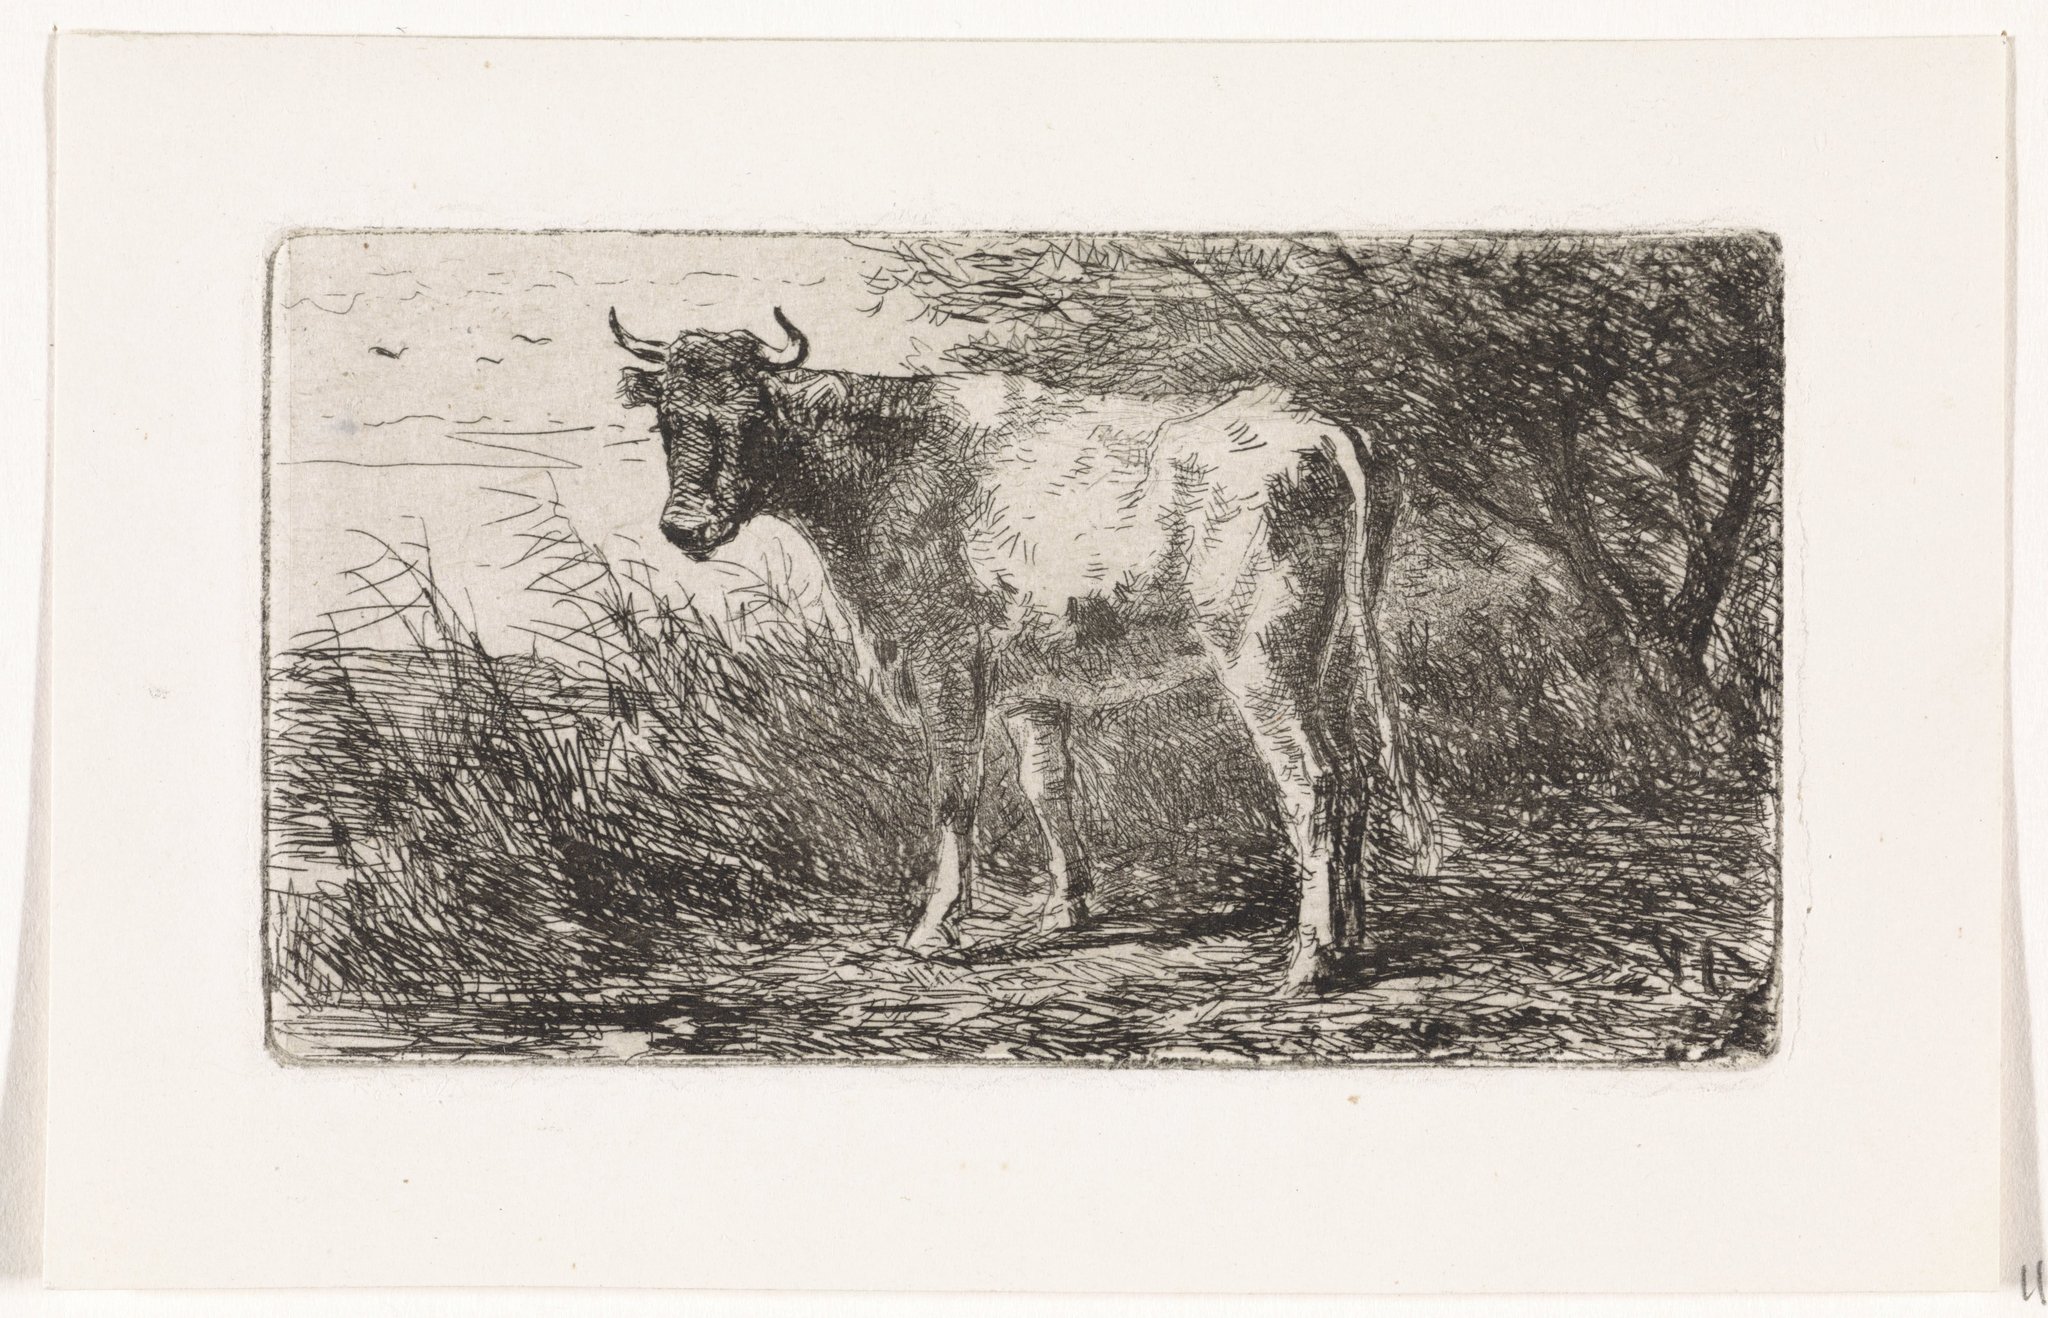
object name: print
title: Koe aan de oever van een rivier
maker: jan vrolijk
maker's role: draughtsman, painter, print maker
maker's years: 1846-1894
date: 1860-1885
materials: paper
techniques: etching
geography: the hague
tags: cow, river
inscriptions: collector's mark: Lugt 2228